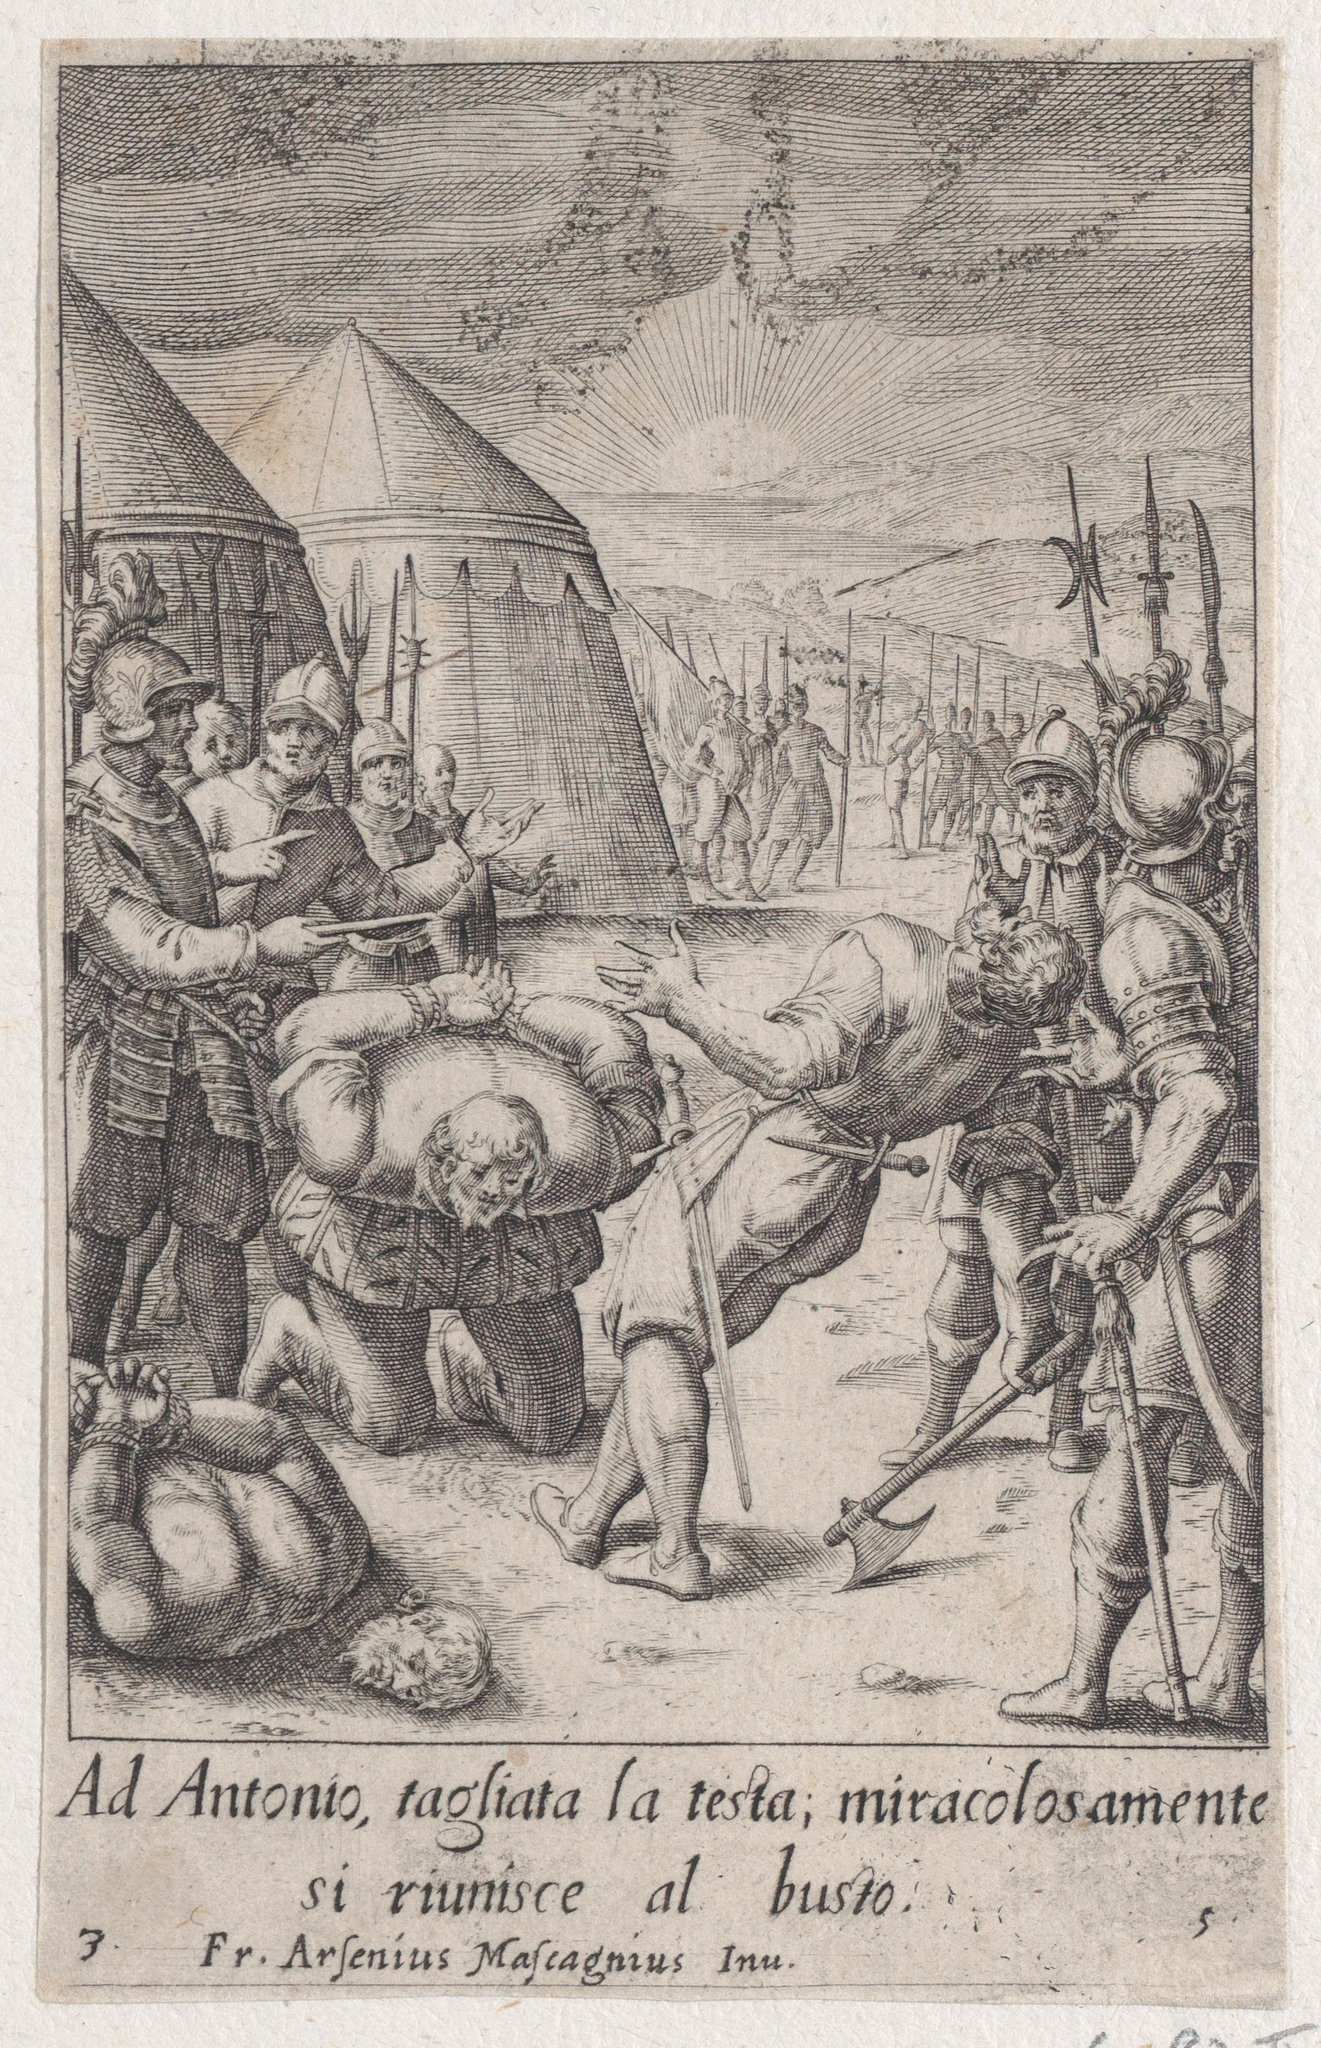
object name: print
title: The Decapitation, from Scelta d'Alcuni Miracoli e Grazie della Santissima Nunziata di Firenze (Selection of Some Miracles and Graces that Occurred in the Church of the Annunziata in Florence)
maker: jacques callot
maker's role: artist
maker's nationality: french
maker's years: 1592-1635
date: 1611-1619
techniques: engraving